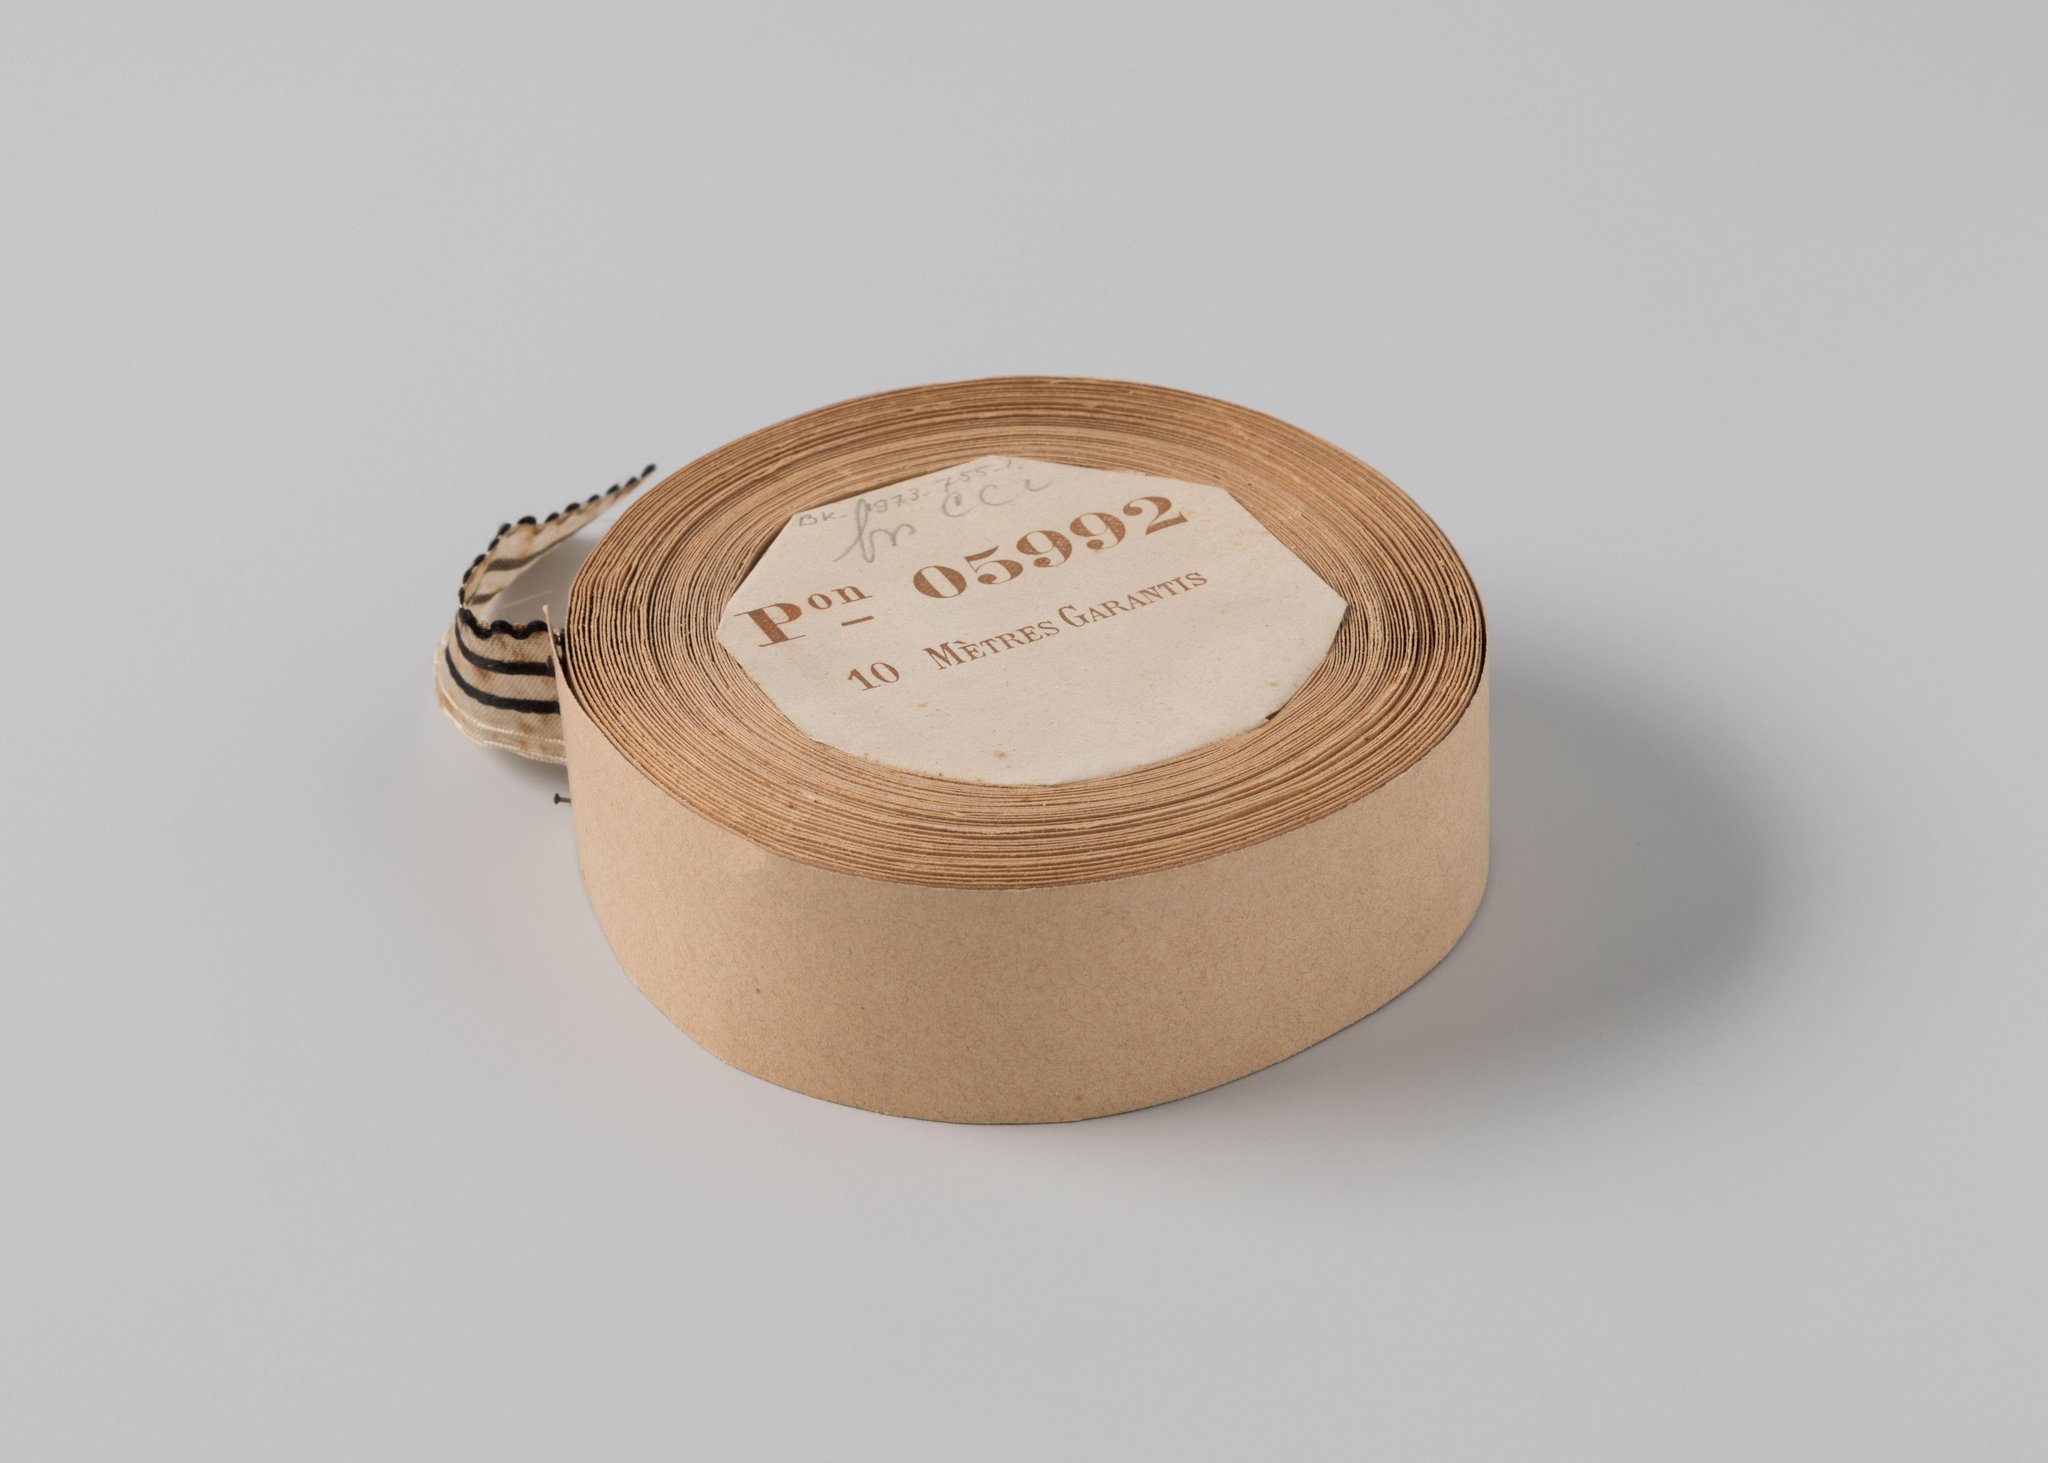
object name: braid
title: Lint op rol, wit satijn met in het midden twee strepen zwart, één zijde is geschulpt en afgezet met een golvende rand in zwart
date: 1890-1935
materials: cardboard, paper, textile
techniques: weave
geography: nijmegen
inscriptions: number: ‘Pon 05992’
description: Lint op rol, wit satijn met in het midden twee strepen zwart, één zijde is geschulpt en afgezet met een golvende rand in zwart.